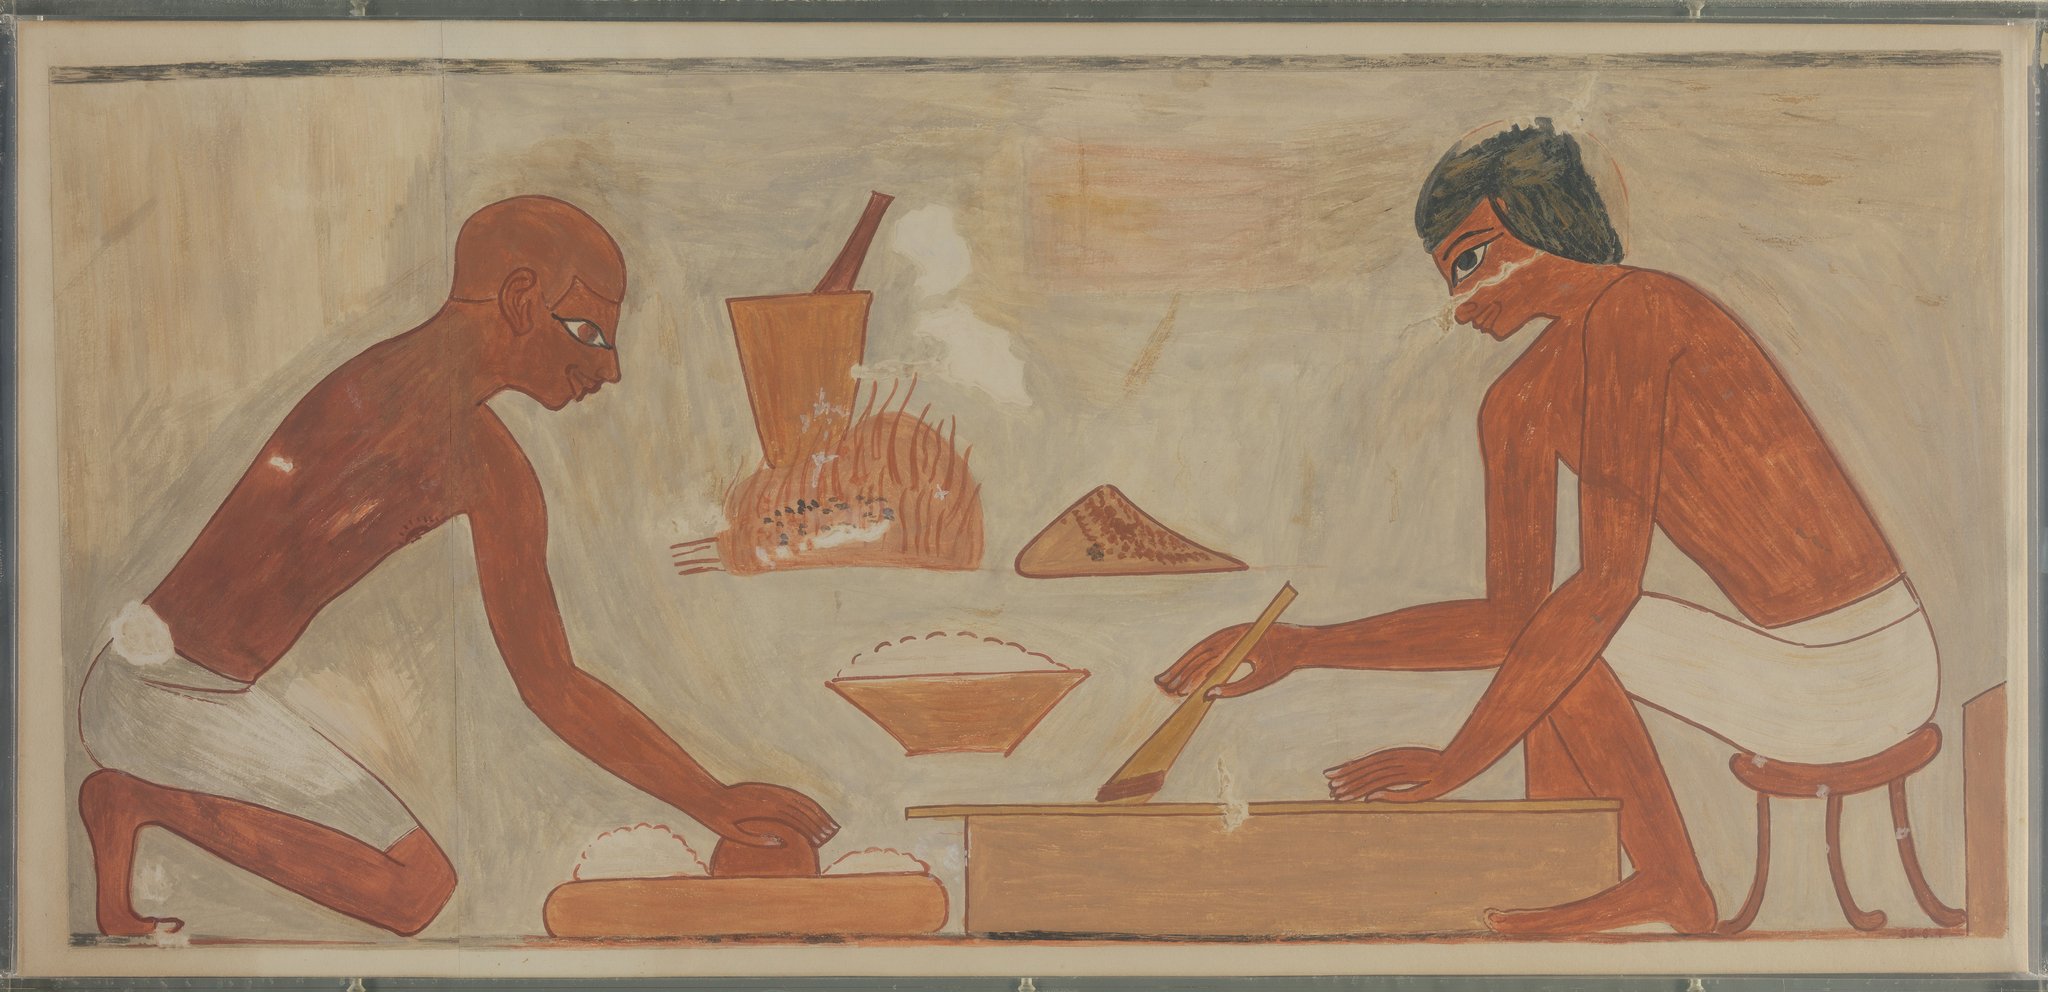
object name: facsimile, rekhmire tt 100, stucco making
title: Gesso Preparation and Application, Tomb of Rekhmire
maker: nina de garis davies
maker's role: artist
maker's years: 1881-1965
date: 1479-1400 BCE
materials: paper, paint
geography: egypt